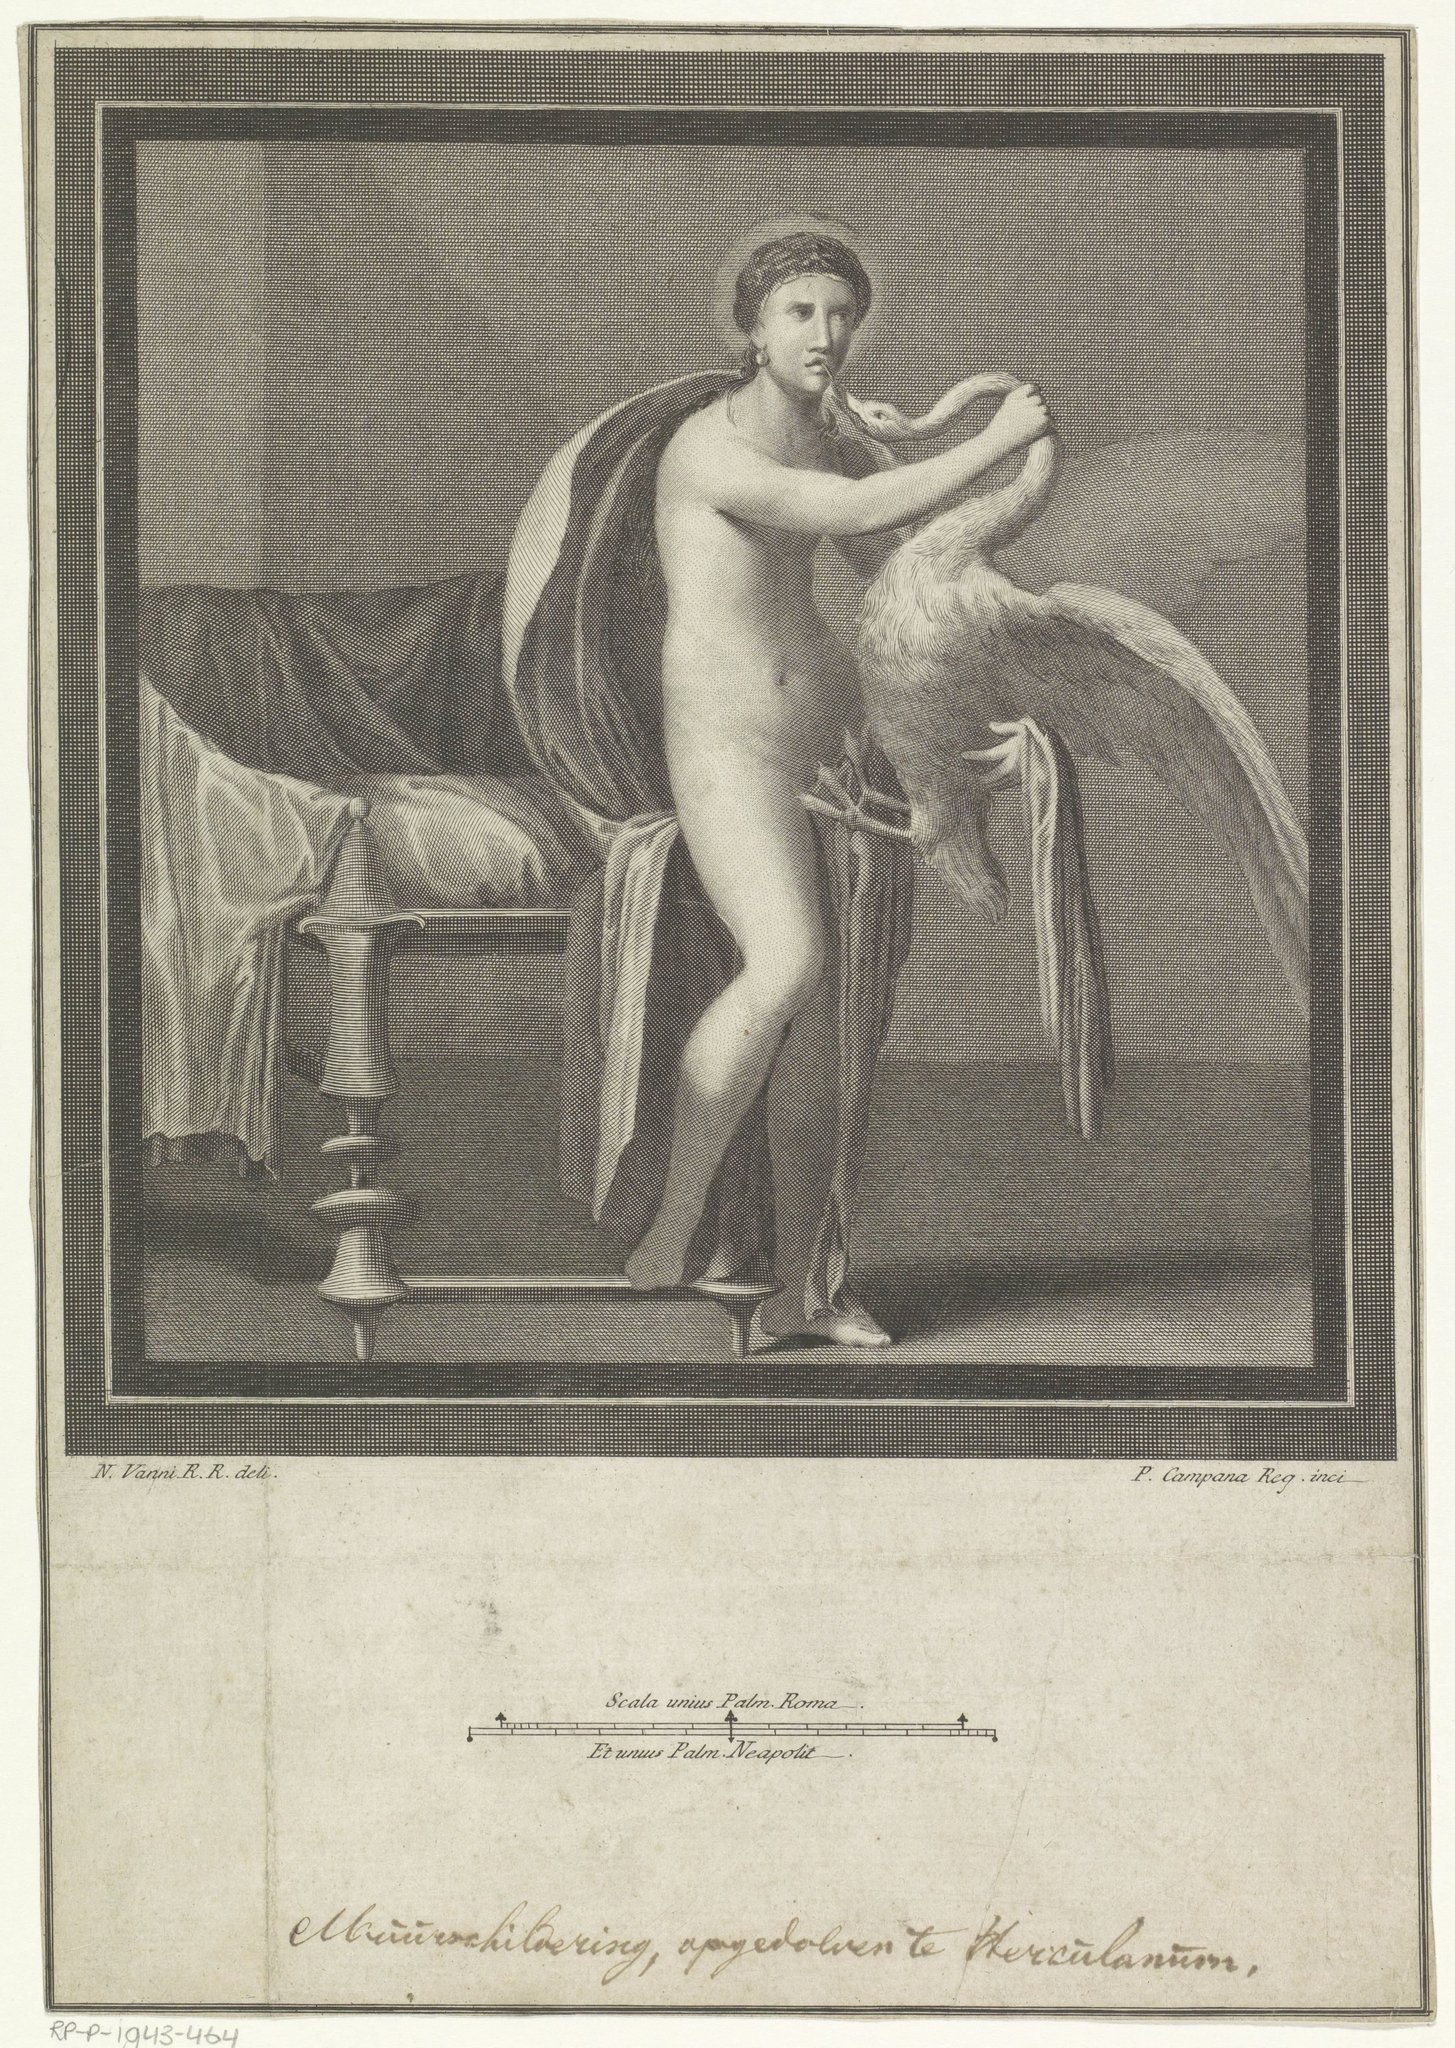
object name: print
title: Leda en de zwaan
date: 1735-1779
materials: paper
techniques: engraving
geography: italy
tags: jupiter, in the shape of a swan, and leda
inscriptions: inscription: ‘Muurschildering opgedoken te Herculanum’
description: Jupiter, in de gedaante van een zwaan, verleidt Leda.